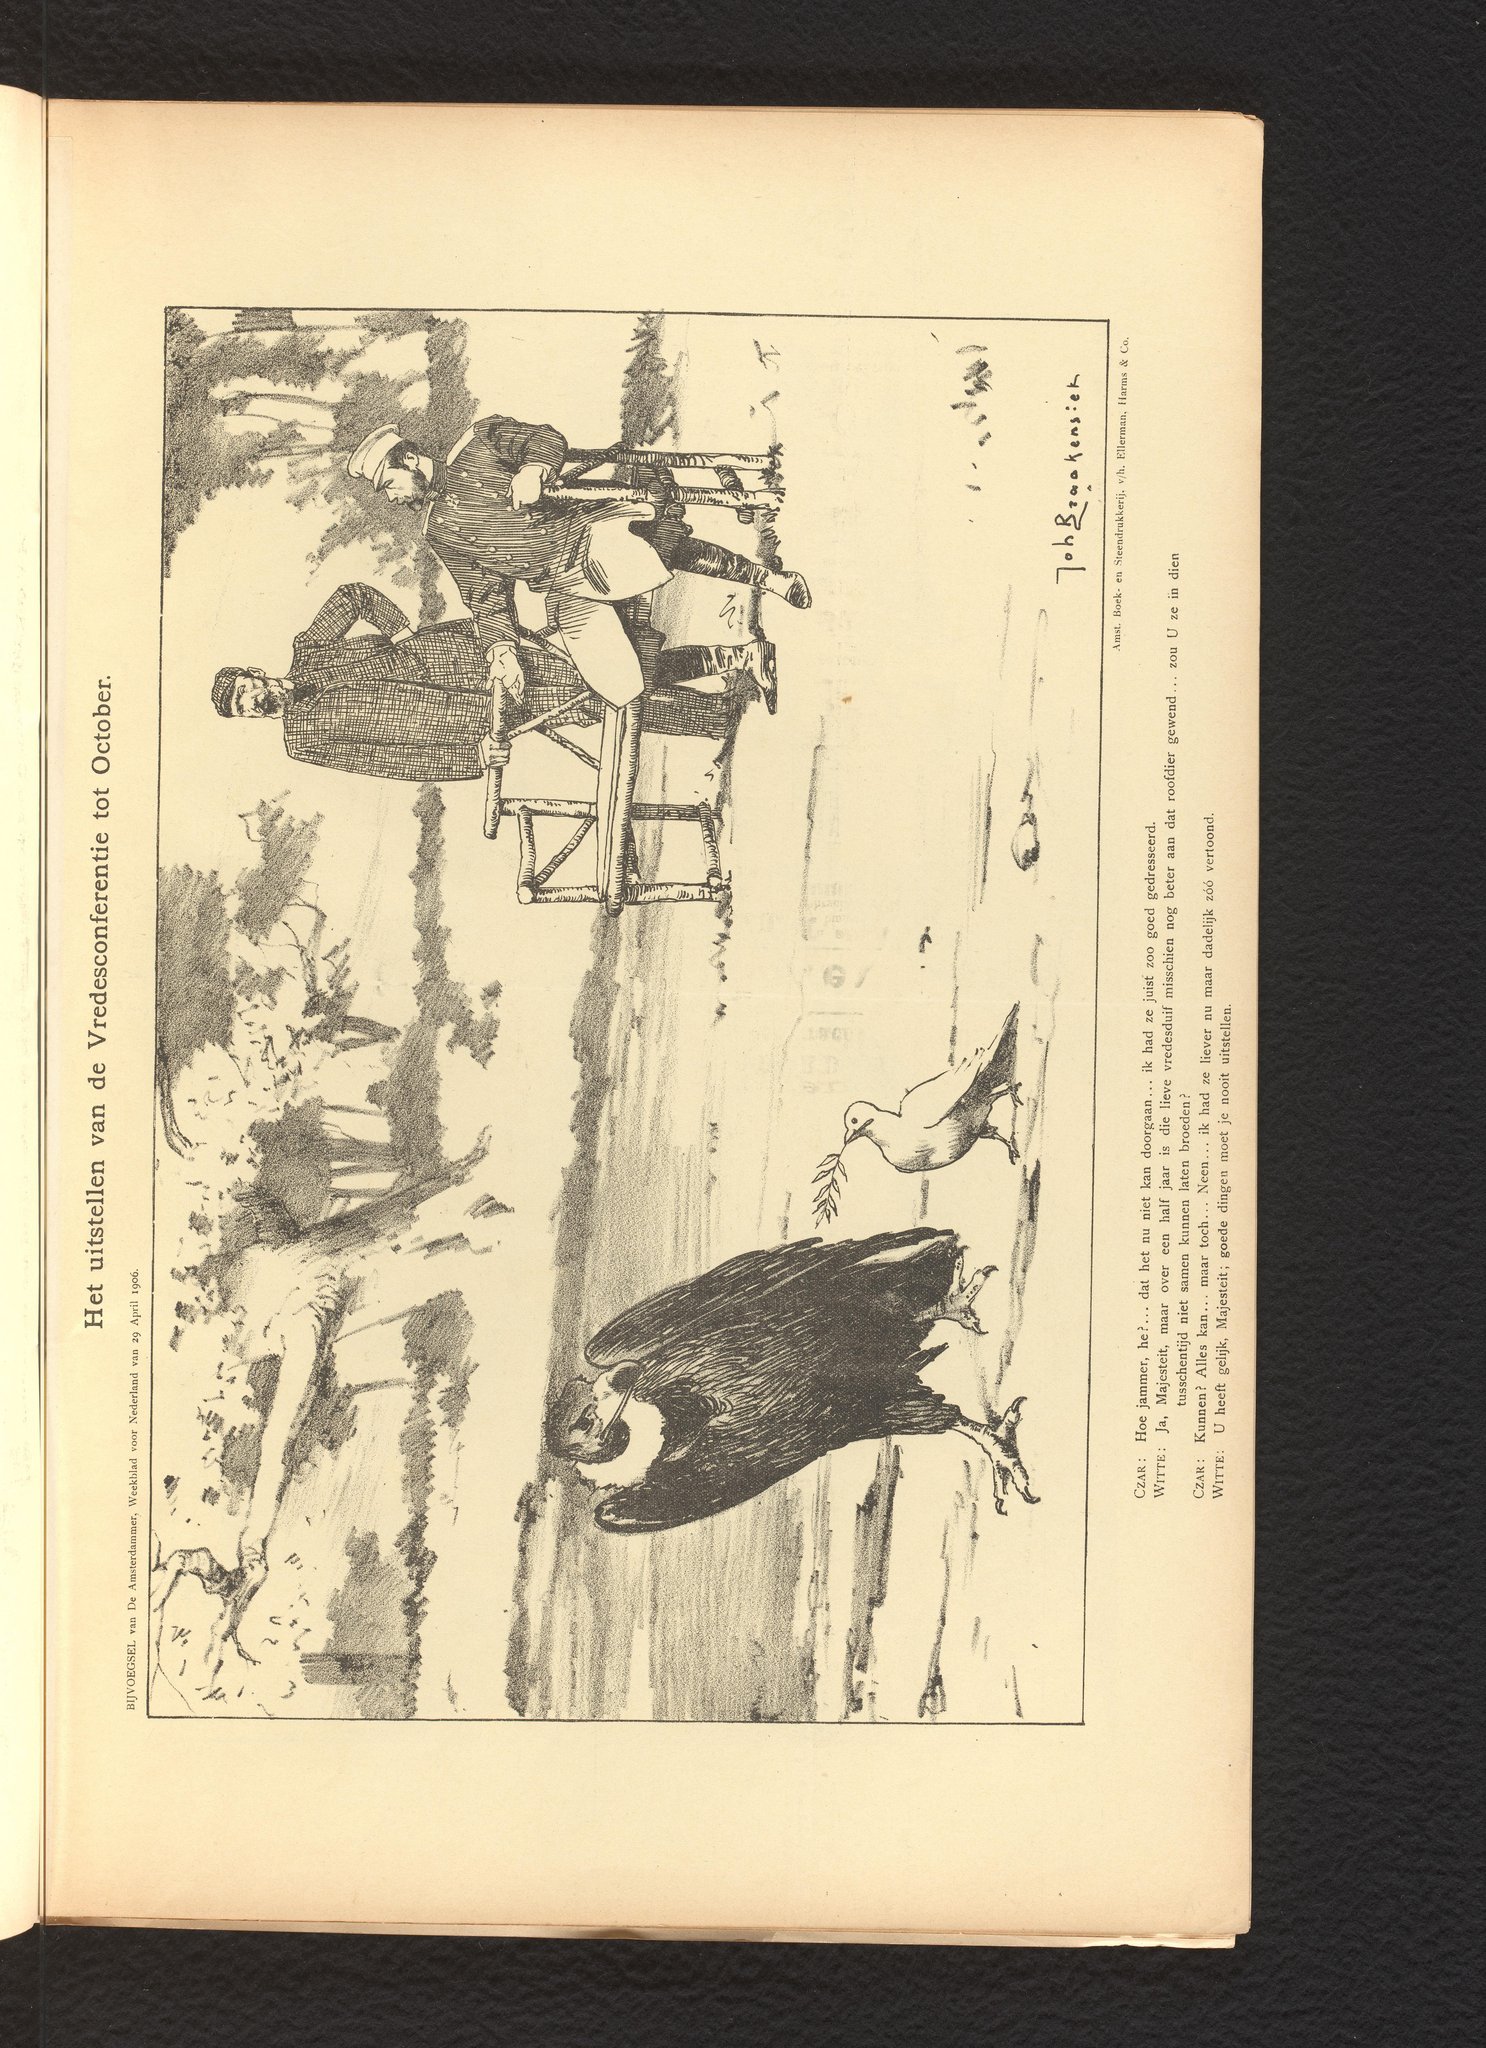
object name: cartoon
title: Het uitstellen van de Vredesconferentie tot October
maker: johan braakensiek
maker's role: draughtsman, print maker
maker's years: 1858-1940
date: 1906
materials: paper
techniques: lithograph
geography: netherlands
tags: other birds: dove, symbols, allegories of peace, 'pax'; 'pace' (ripa), peace negotiations, predatory birds: vulture, political caricatures and satires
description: De Russische minister van Buitenlandse Zaken Sergei Witte en tsaar Nicolaas II betreuren het uitstellen van de Tweede Haagse Vredesconferentie naar 1907. Op de voorgrond de vredesduif en een gier.